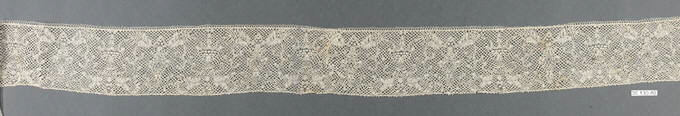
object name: edging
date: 1701-1733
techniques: lace